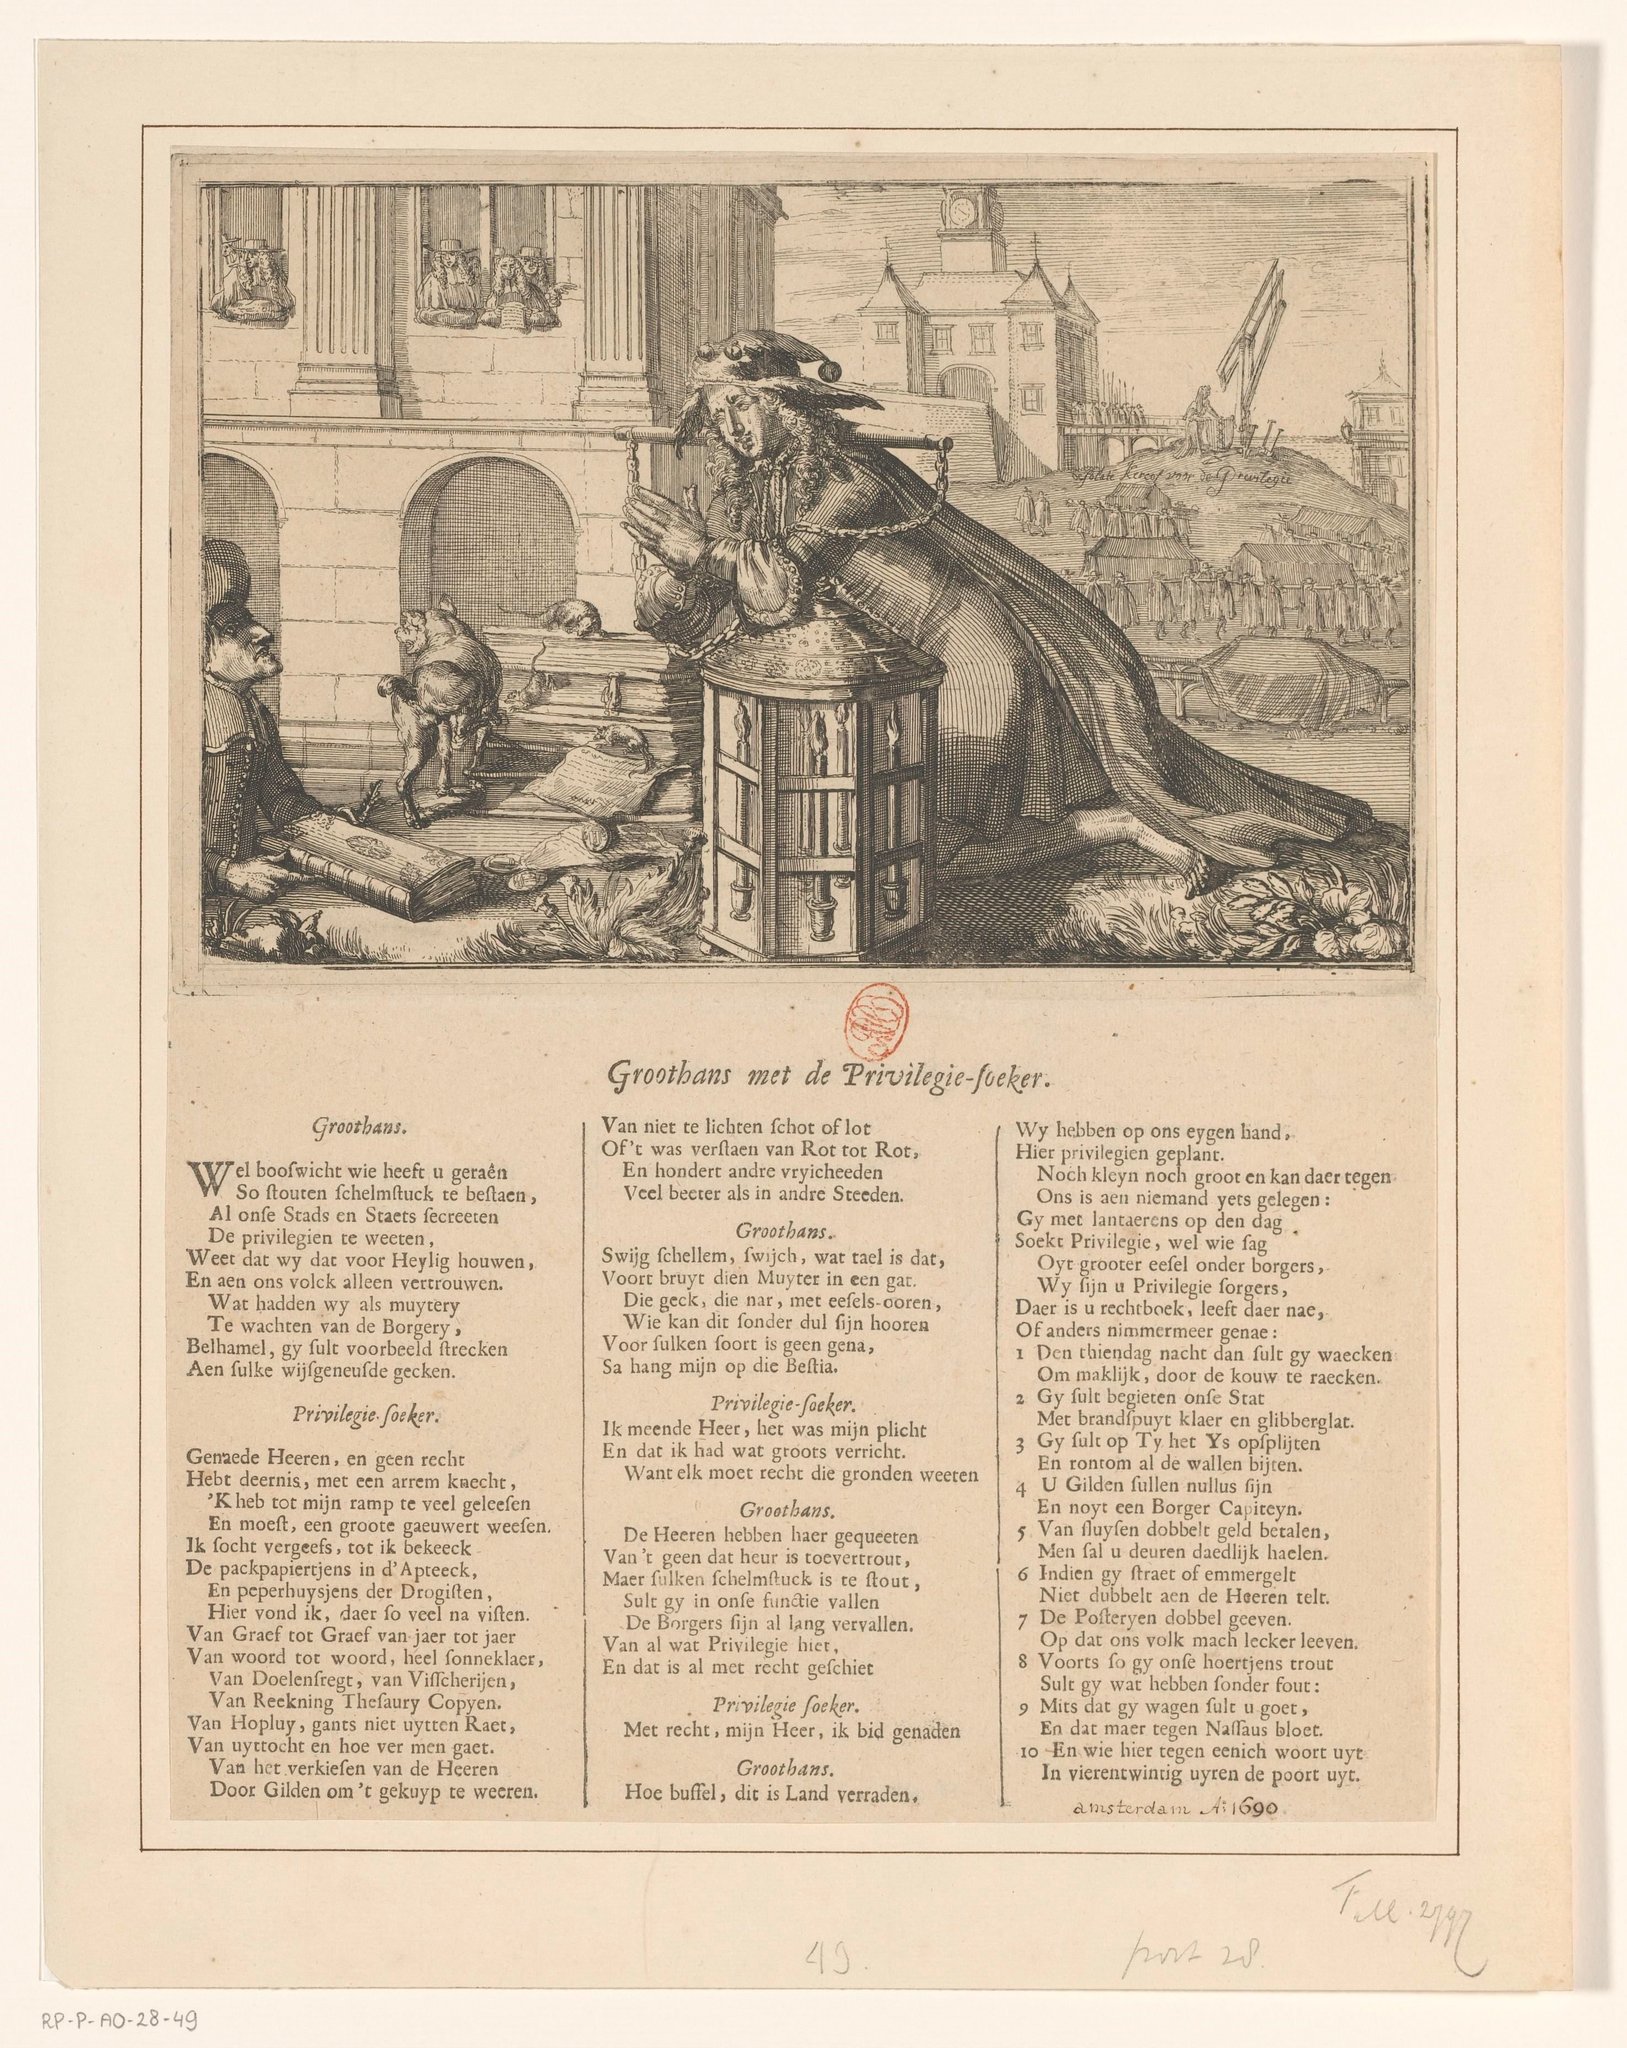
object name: print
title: Spotprent op de regenten van Amsterdam, 1690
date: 1690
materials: ink, paper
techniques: etching, letterpress printing, pen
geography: northern netherlands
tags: political caricatures and satires, amsterdam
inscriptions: inscription: ‘Amsterdam Ao. 1690’, collector's mark: Lugt 195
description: Spotprent op de regenten van Amsterdam, 1690: Groothans en de Privilege-zoeker. De Privilege-zoeker (de burgerij van Amsterdam) knielt smekend en huilend met een juk op de schouders bij een grote stadslantaarn (waarmee hij privileges zoekt), terwijl links Groothans (een regent) hem een boek (mogelijk een privilegeboek) aanreikt. Links een stapel privileges van Amsterdam waaraan ratten knagen en waartegen een hond plast. Op de achtergrond rechts een begrafenisstoet op een kerkhof aangeduid als: desolate Kercof voor de Previlegie. Op het blad onder de plaat een bijhorende tekst in drie kolommen eindigend met een lijst van tien geboden.